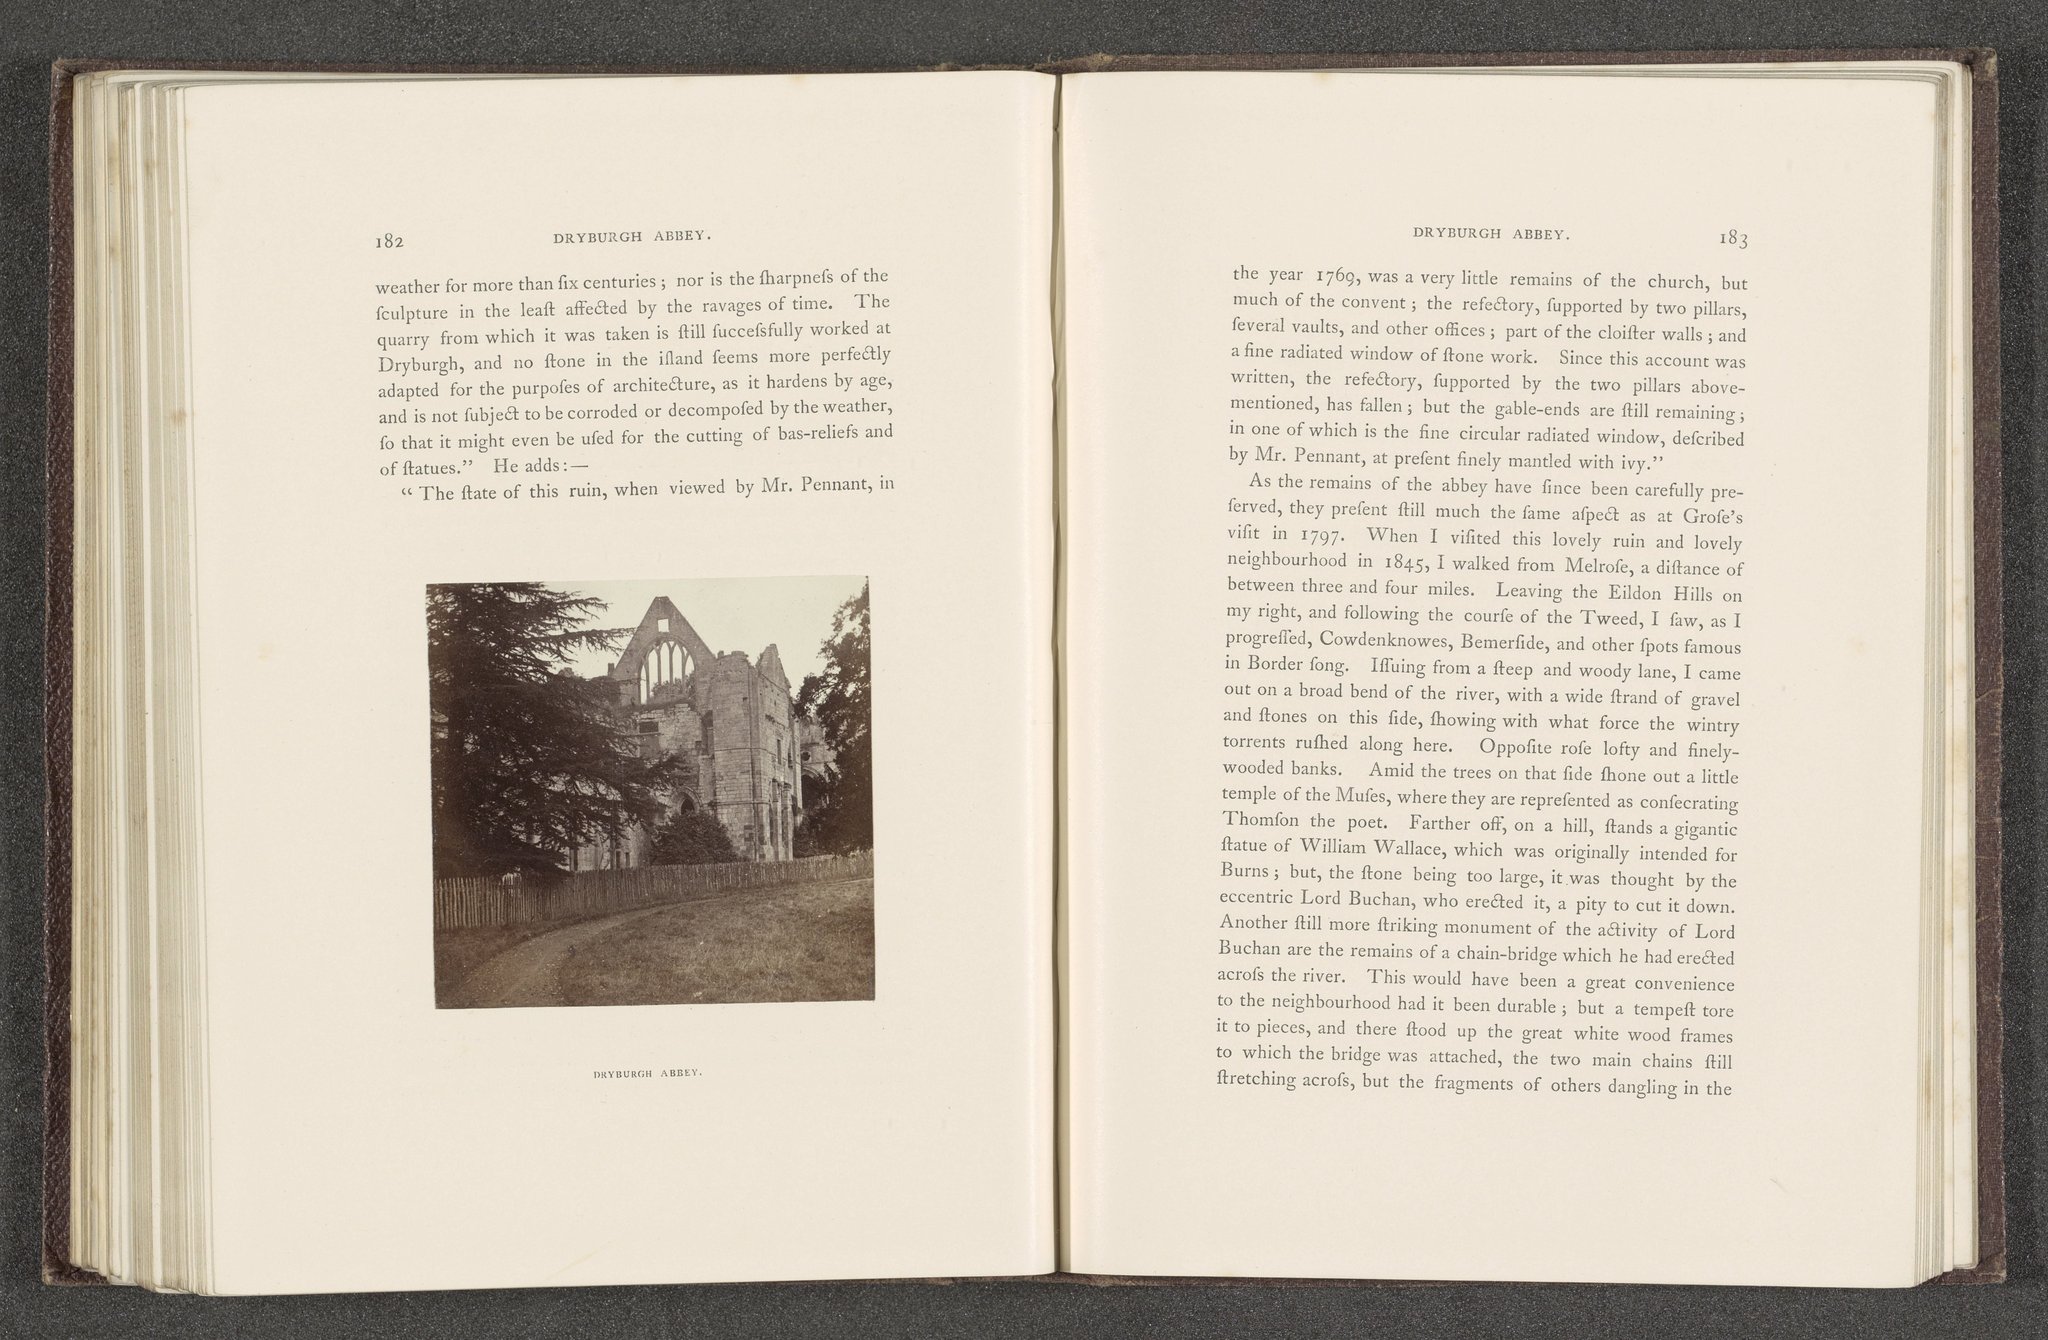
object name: page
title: Dryburgh Abbey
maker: stephen thompson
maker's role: fotograaf, schrijver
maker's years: 1831-1893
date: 1854-1864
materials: photographic support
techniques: albumen print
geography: dryburgh abbey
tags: ruin of church, monastery, etc.